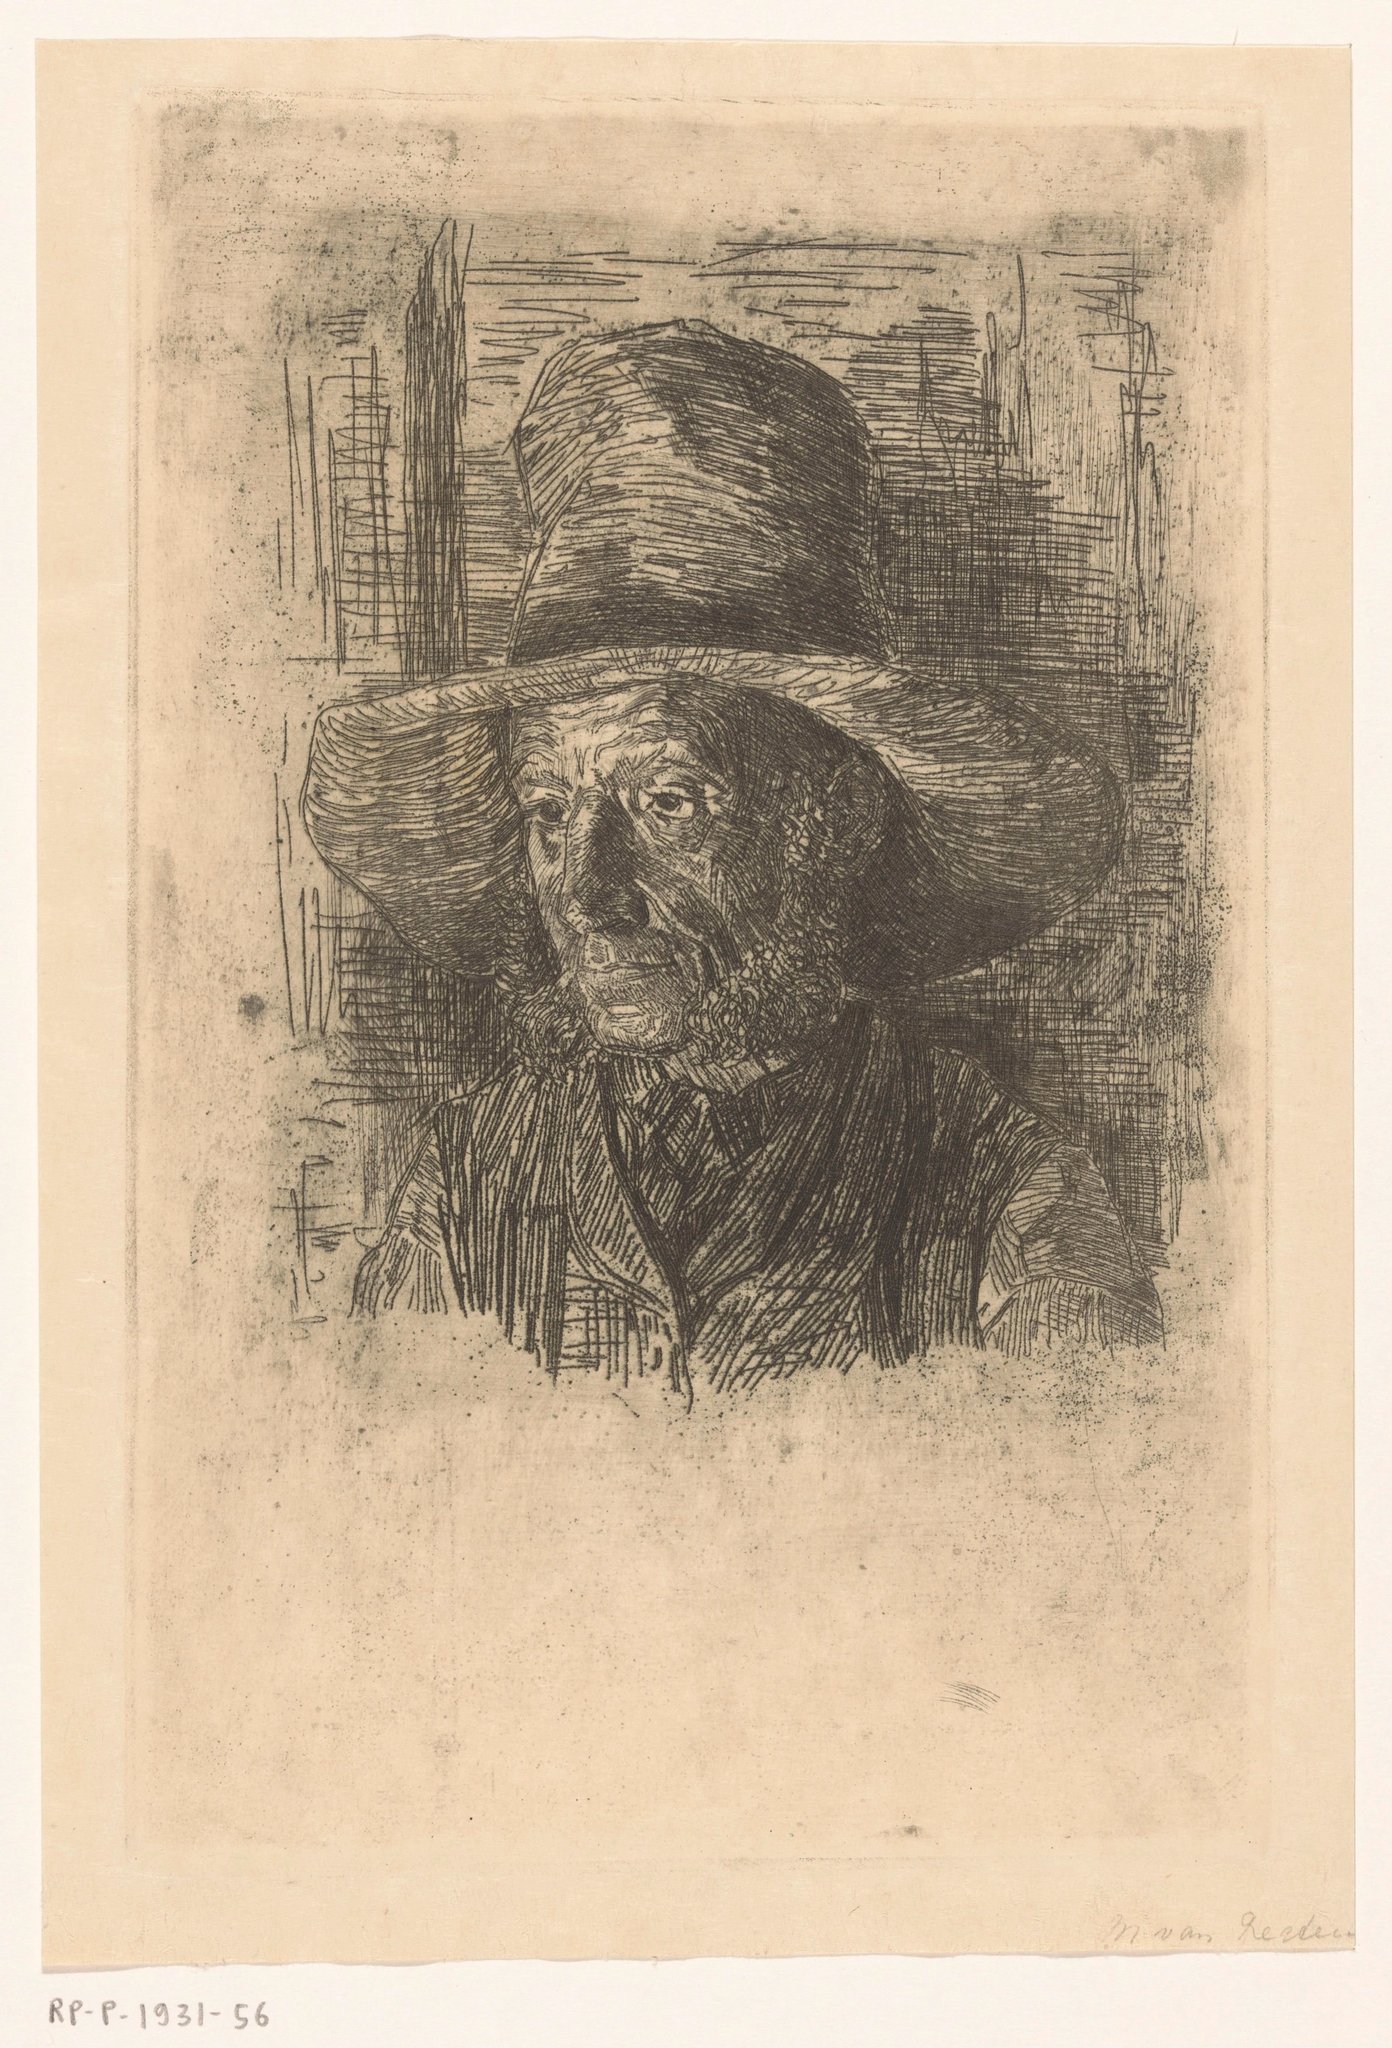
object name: print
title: Portret van een onbekende man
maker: martinus van regteren altena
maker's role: painter, print maker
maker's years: 1866-1908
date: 1876-1908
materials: paper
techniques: etching, intaglio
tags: head-gear: hat (+ men's clothes), anonymous historical person portrayed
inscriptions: collector's mark: Lugt 2228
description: De man draagt een hoed en heeft bakkebaarden.